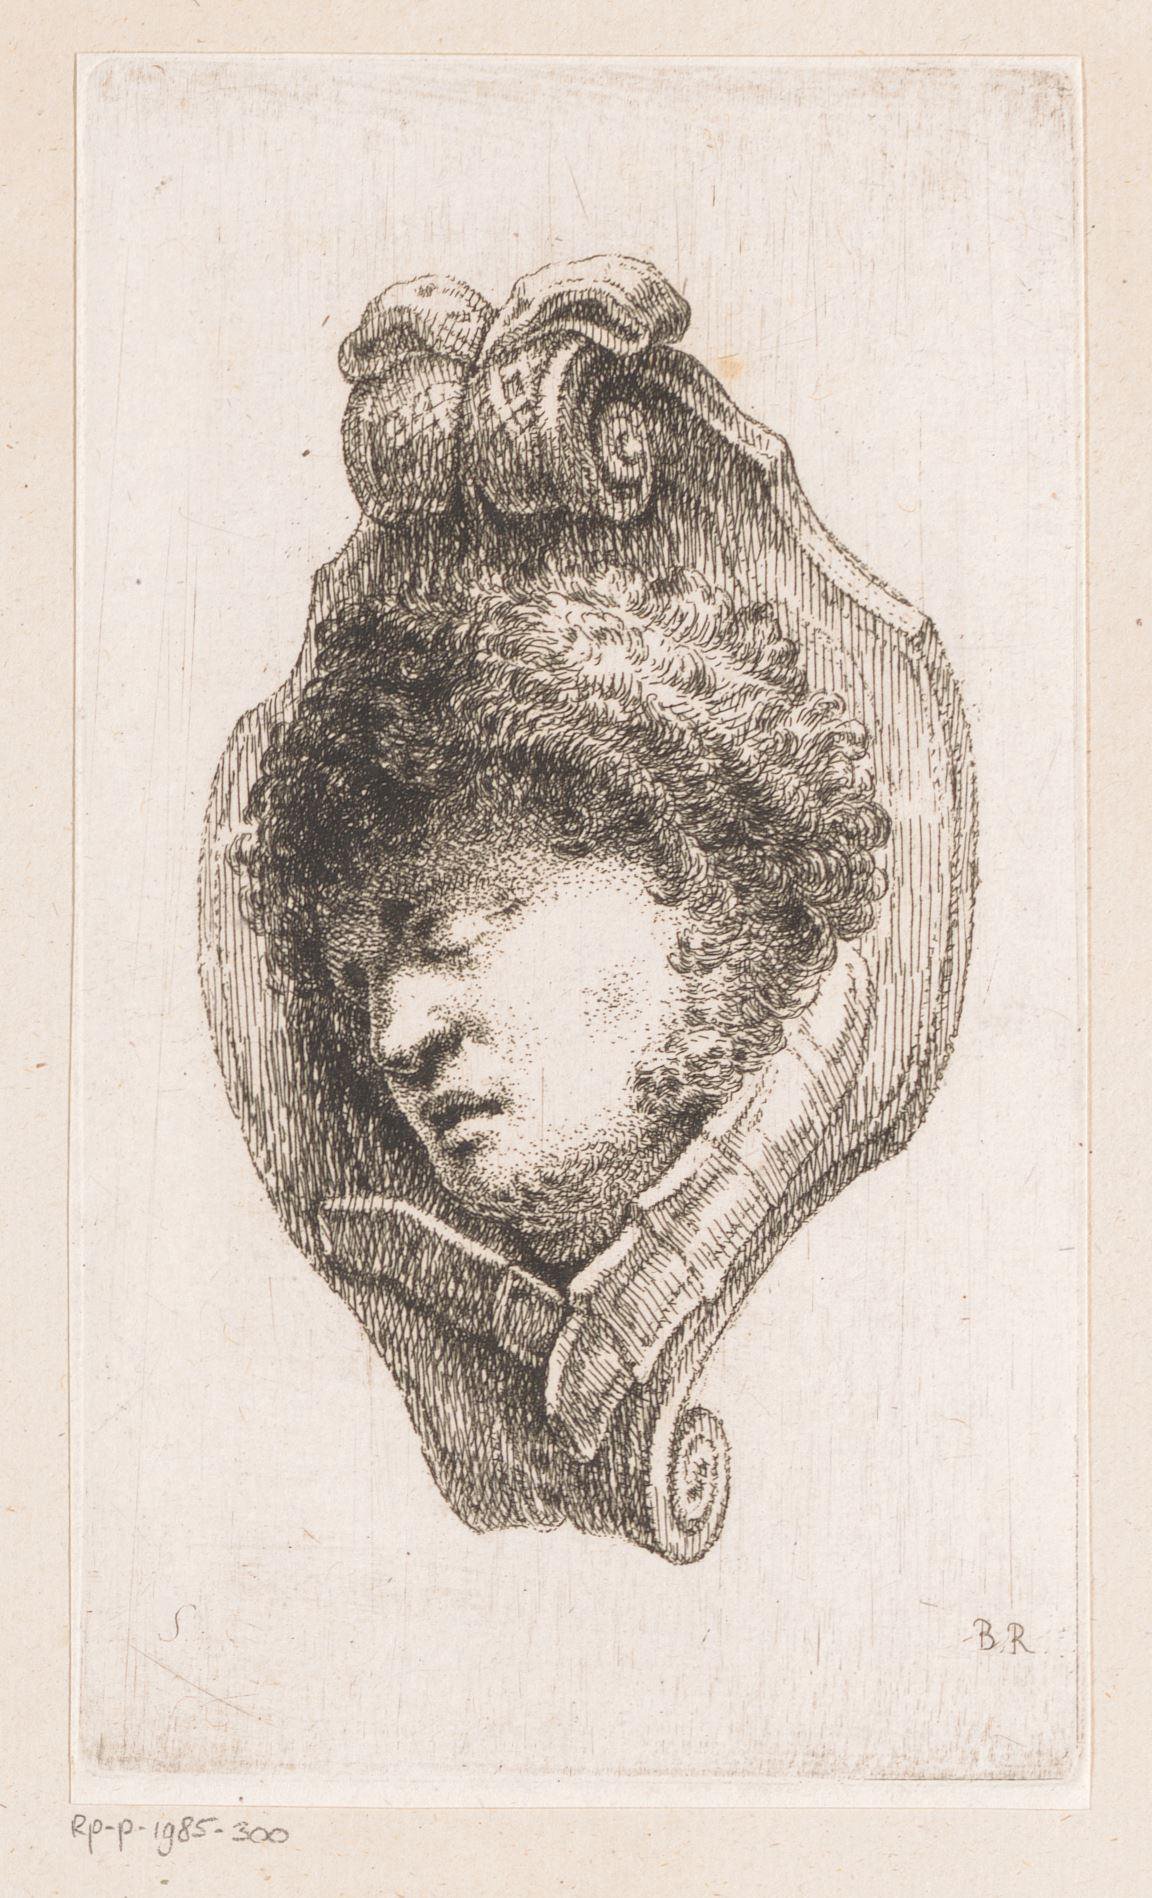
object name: print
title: Mascarons en helmen van het Zeughaus te Berlijn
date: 1759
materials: paper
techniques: etching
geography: berlin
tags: mask, mascaron ~ ornament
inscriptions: collector's mark: Lugt 2760, collector's mark: Lugt 2228